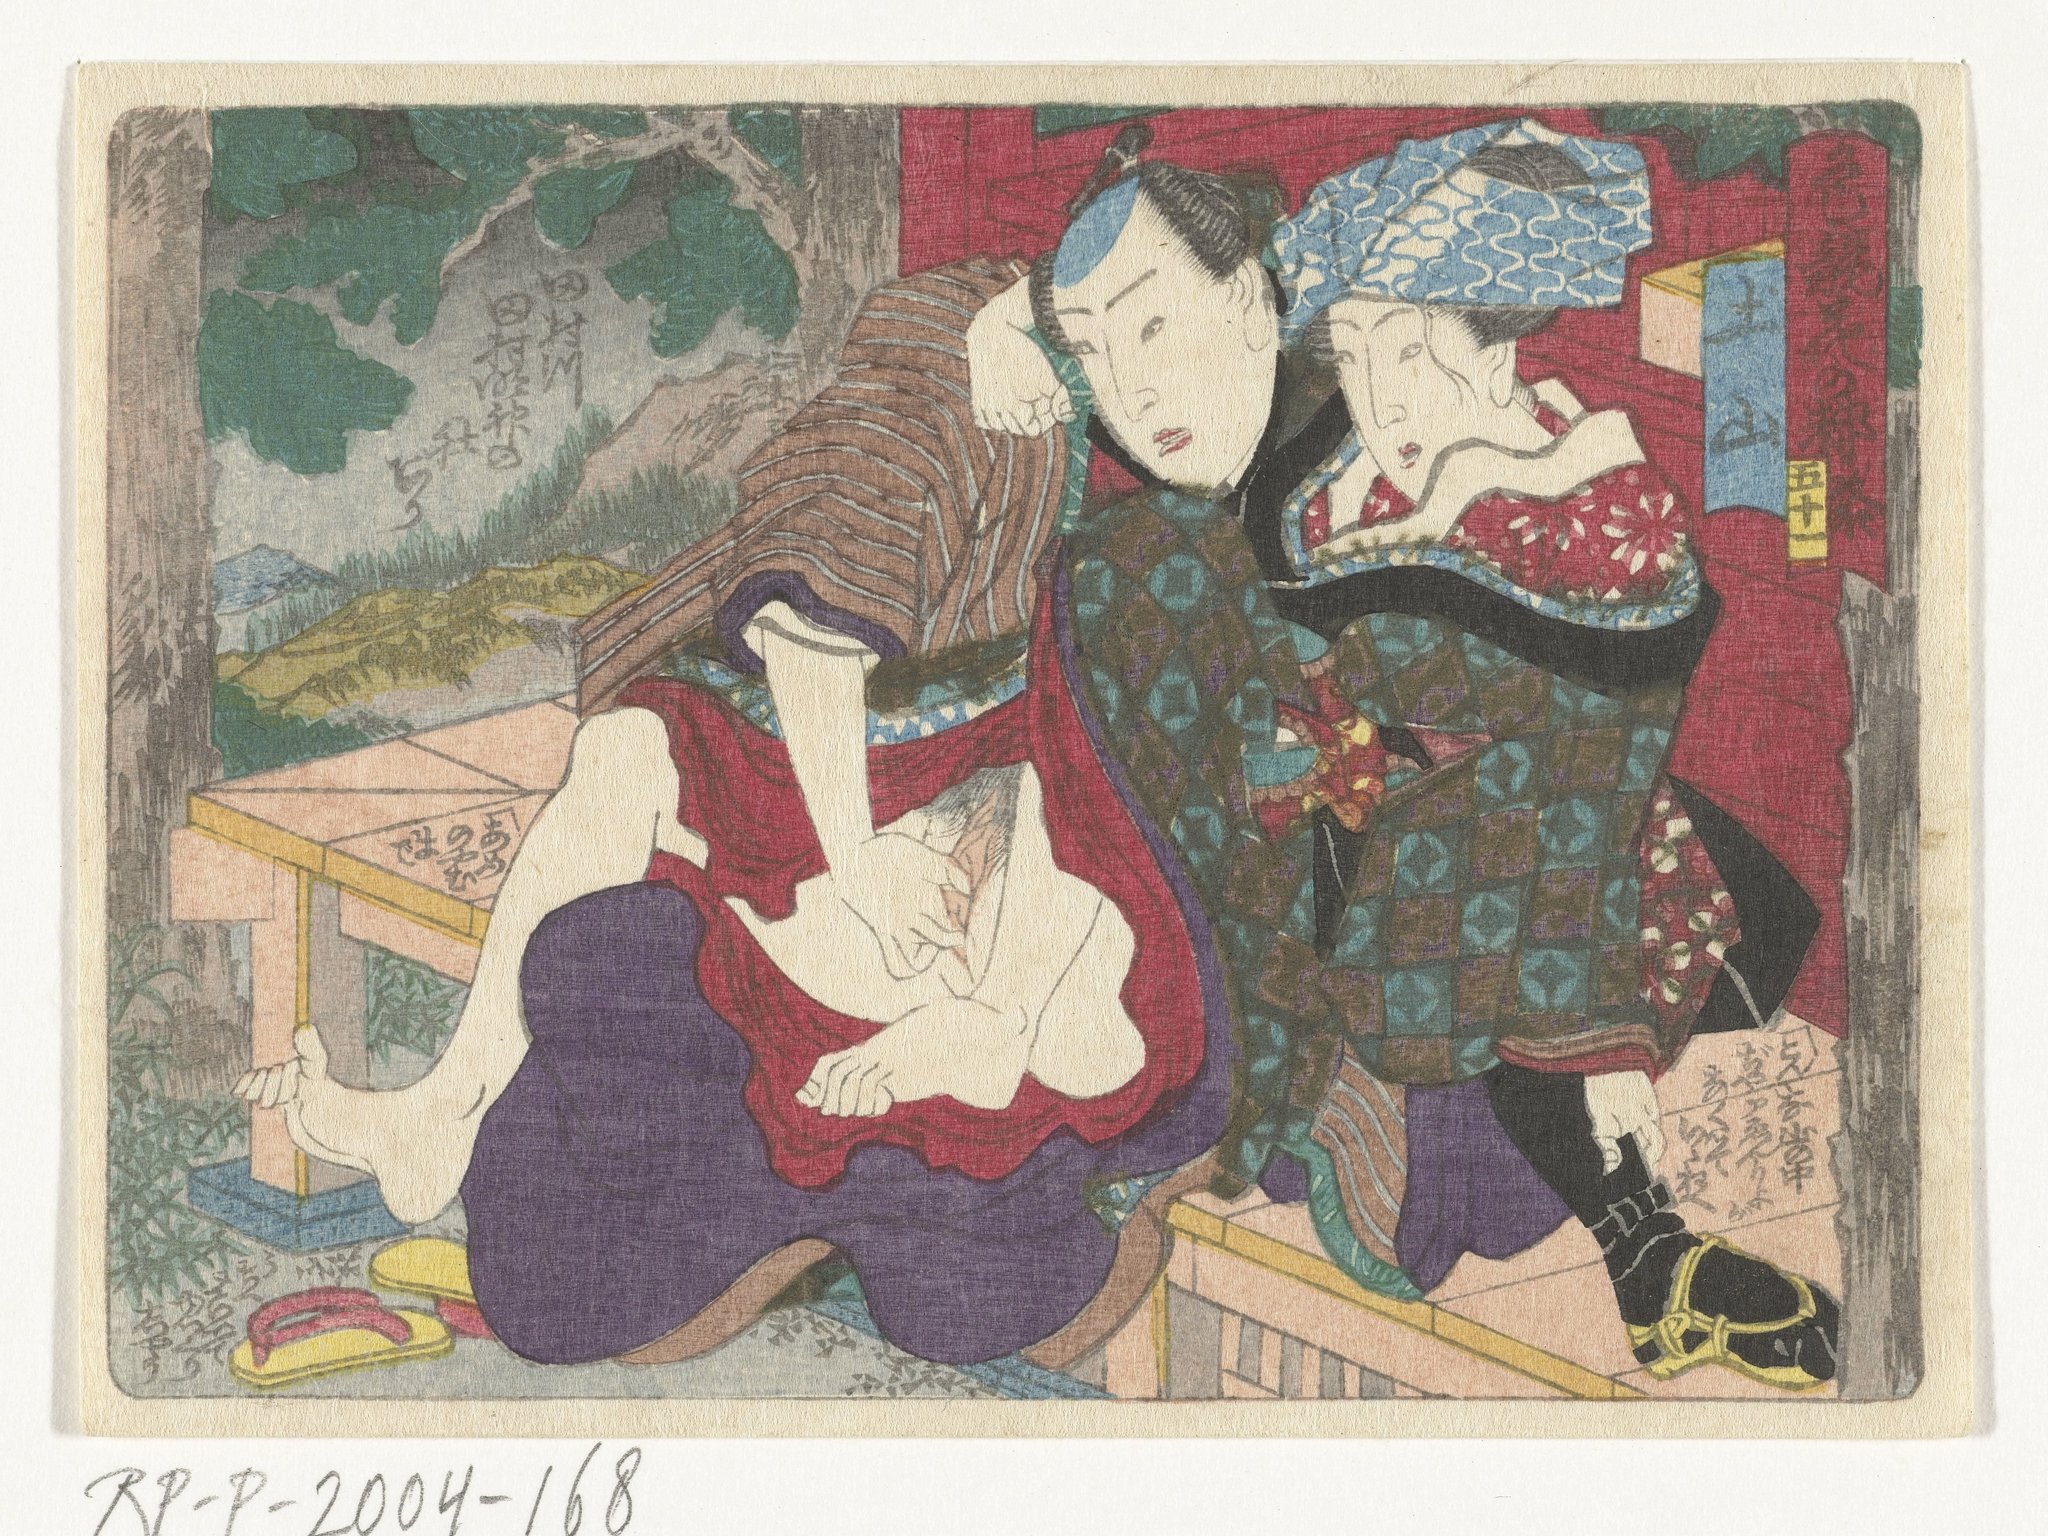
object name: print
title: De erotische weg naar de hoofdstad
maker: utagawa kunisada (i)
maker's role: print maker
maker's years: 1786-1865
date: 1835-1845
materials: paper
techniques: woodcut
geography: japan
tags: coitus, cohabiting, sexual intercourse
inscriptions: collector's mark: Lugt 2228, collector's mark: Lugt 2760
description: Man en vrouw de liefde bedrijvend op veranda; pijnbomen op de achtergrond.